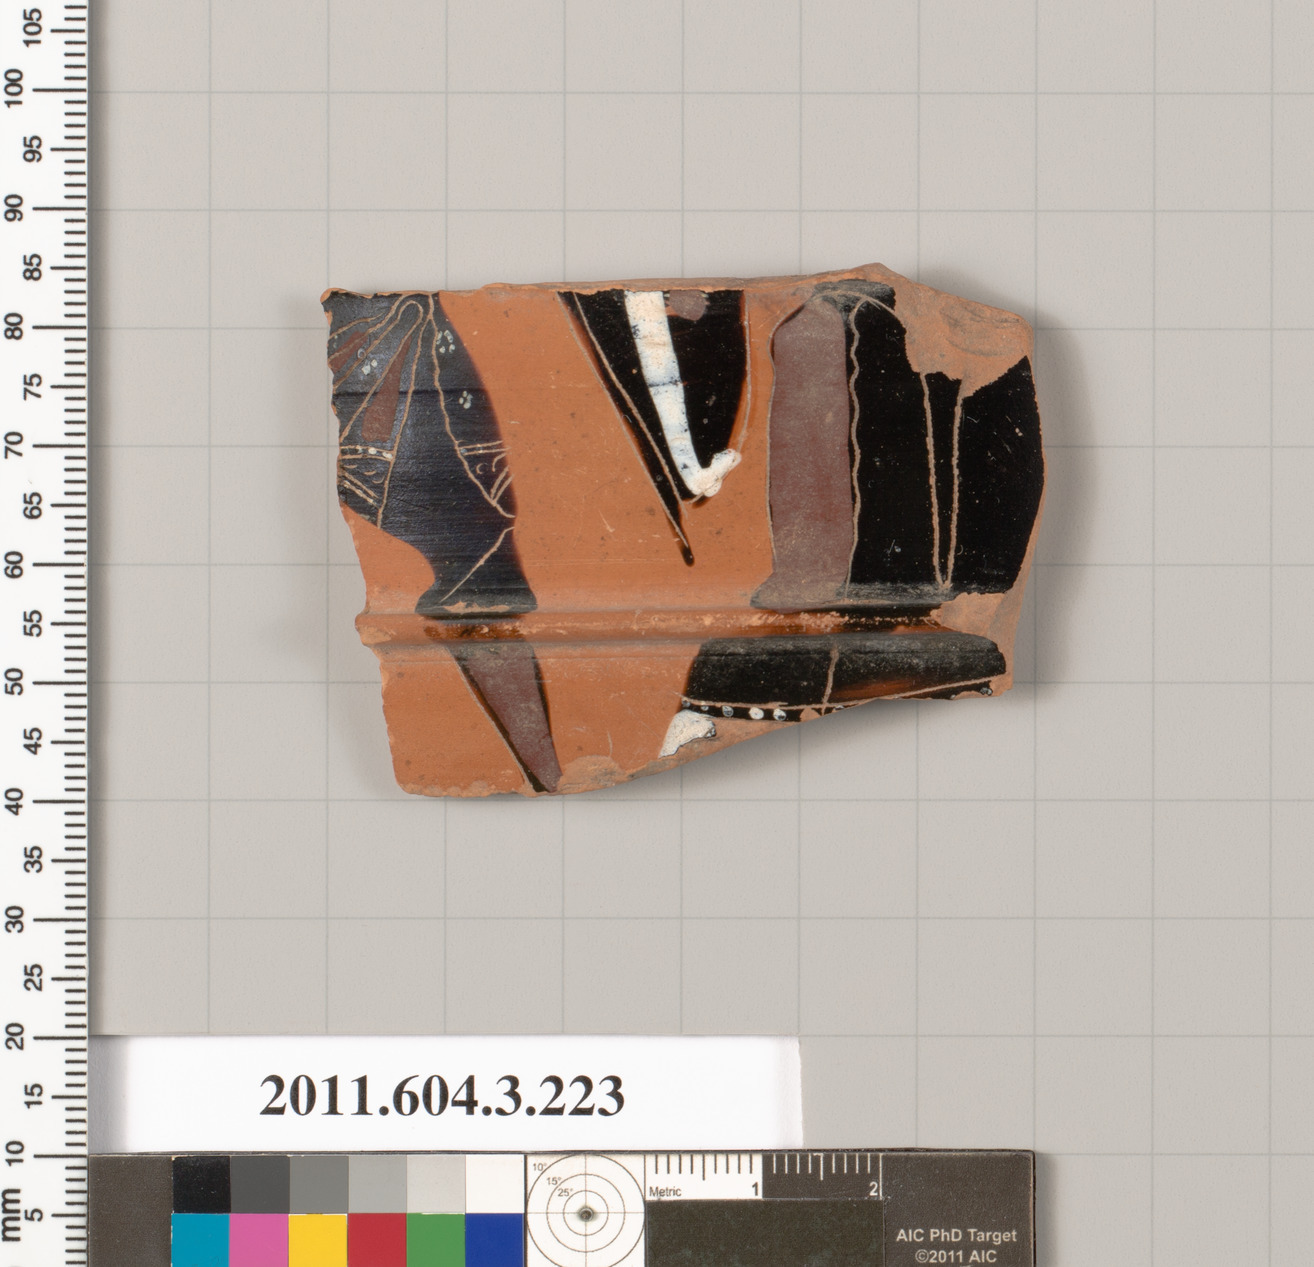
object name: neck amphora fragment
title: Terracotta fragment of a neck-amphora of Nicosthenic shape (jar)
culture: greek, attic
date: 525-501 BCE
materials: terracotta